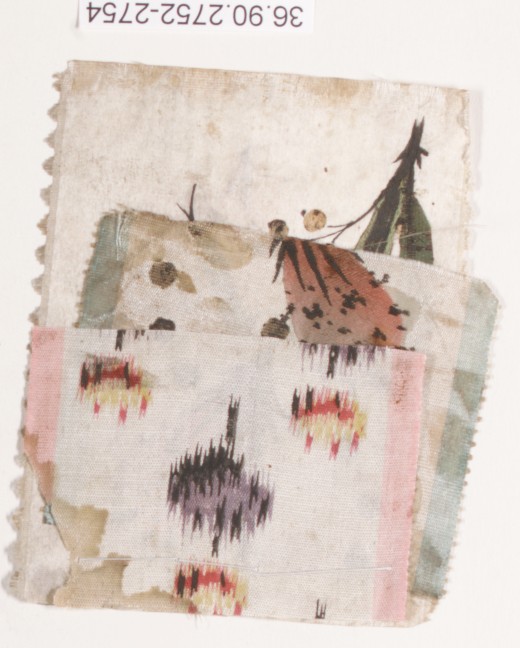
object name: ribbon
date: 1801-1900